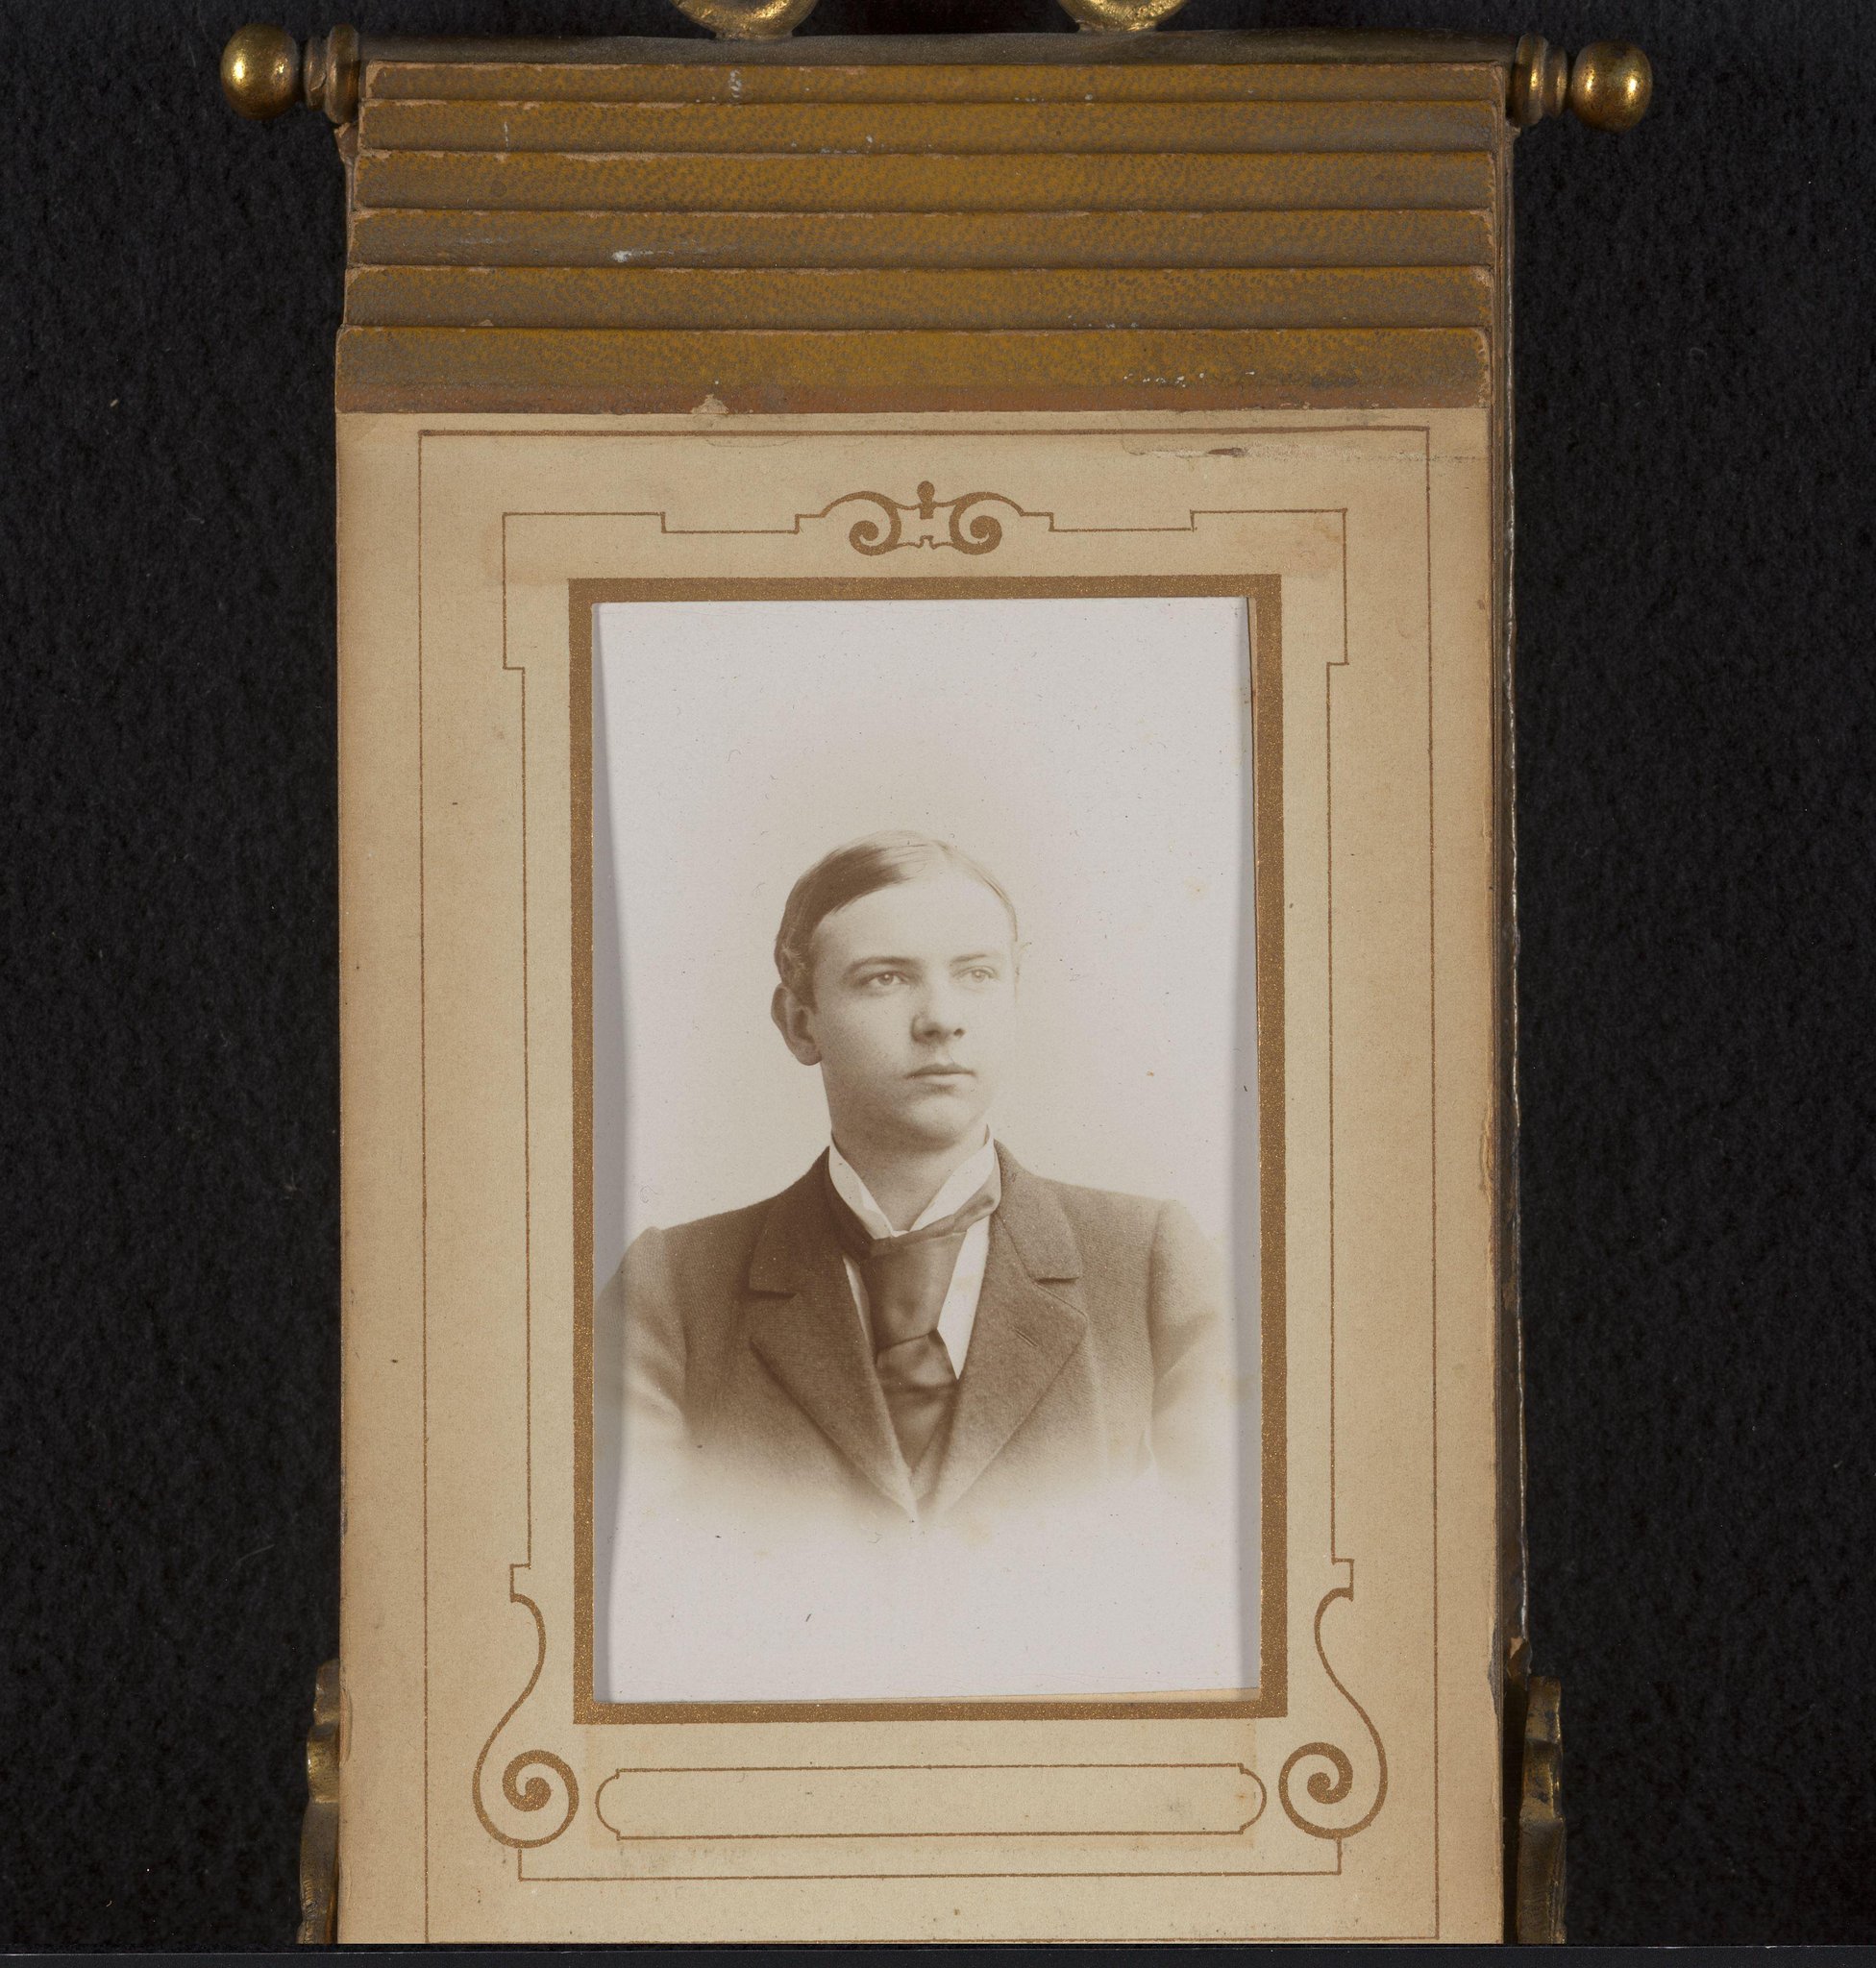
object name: photograph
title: Portret van een jonge man met stropdas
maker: alex putzar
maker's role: fotograaf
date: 1897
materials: cardboard, photographic support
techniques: collodion silver print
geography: greifswald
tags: historical persons, youth, adolescent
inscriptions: inscription: ‘Alex Putzar/ Photogr. Atelier/ Greifswald/ 53, Bahnhofstr. 53/ Gegr. 1876./ Die Platte bleibt für Nachbestellungen aufbewahrt.’, annotation: ‘[....]/ 5. 18/ Ph/ 97 5.’